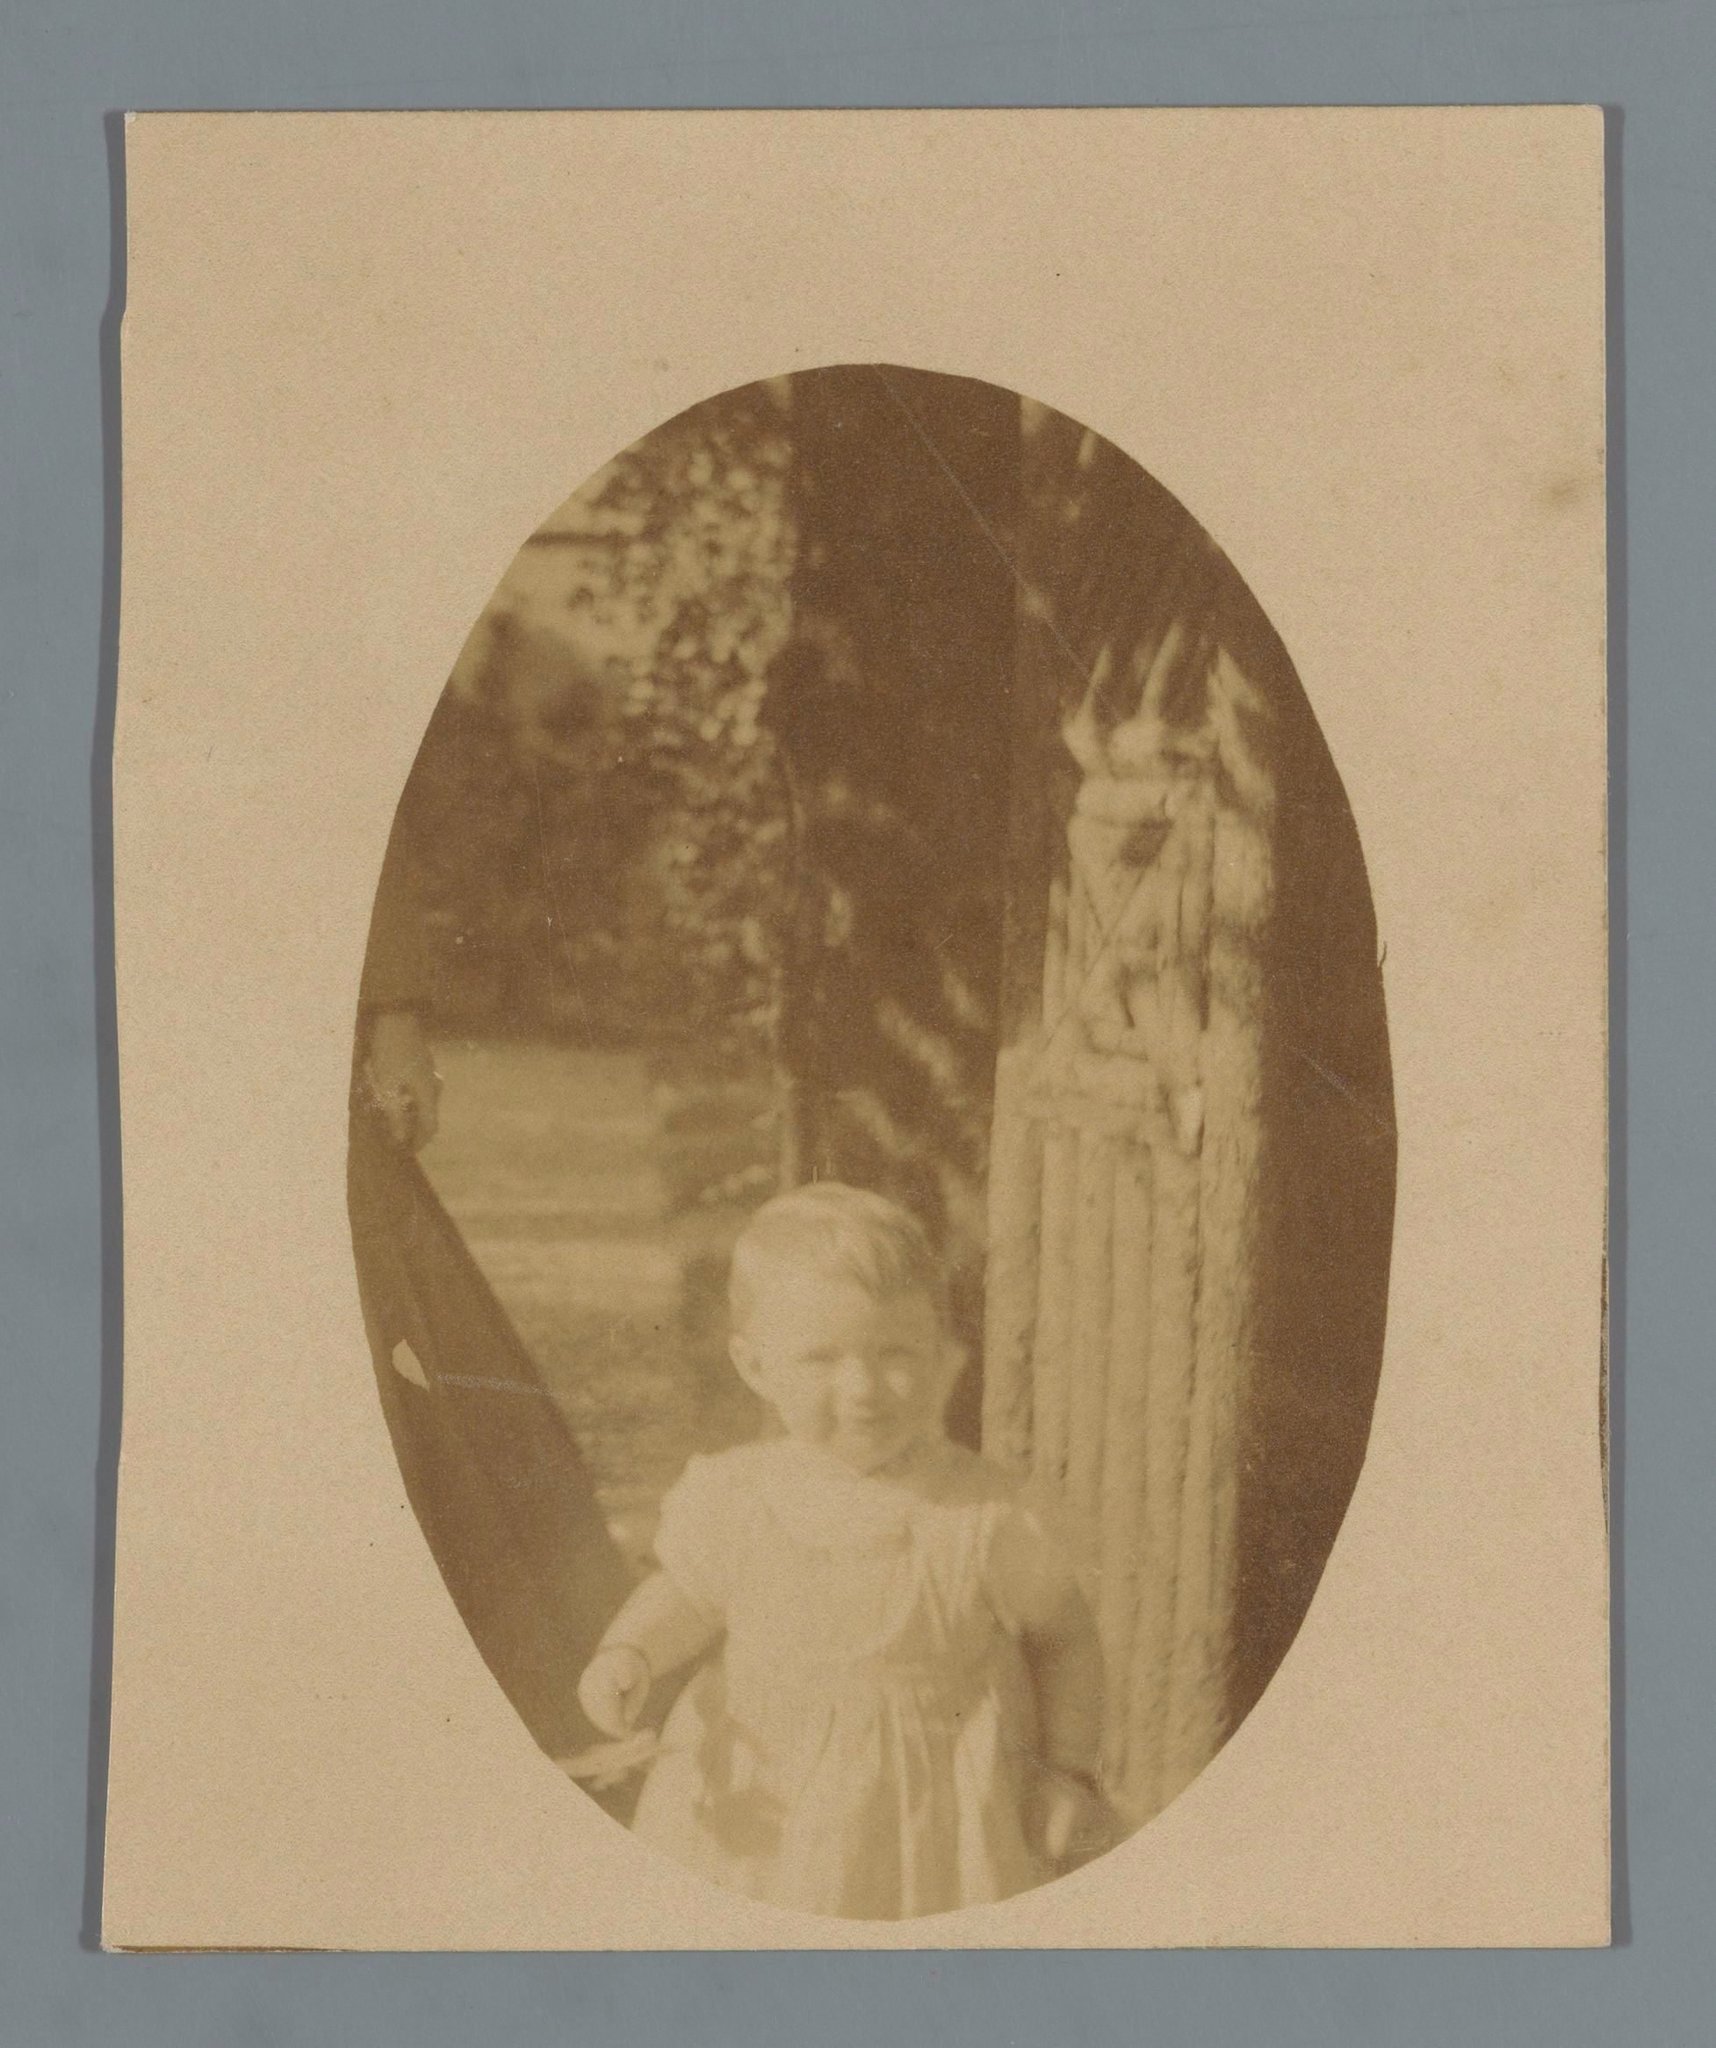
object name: photograph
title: Kinderportret van Alida Christiana van der Mey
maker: Anonymous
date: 1905-1920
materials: photographic support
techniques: gelatin silver print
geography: netherlands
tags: infant, baby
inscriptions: inscription: ‘Alida Christiana van der Mey oud 15 1/2 maand’